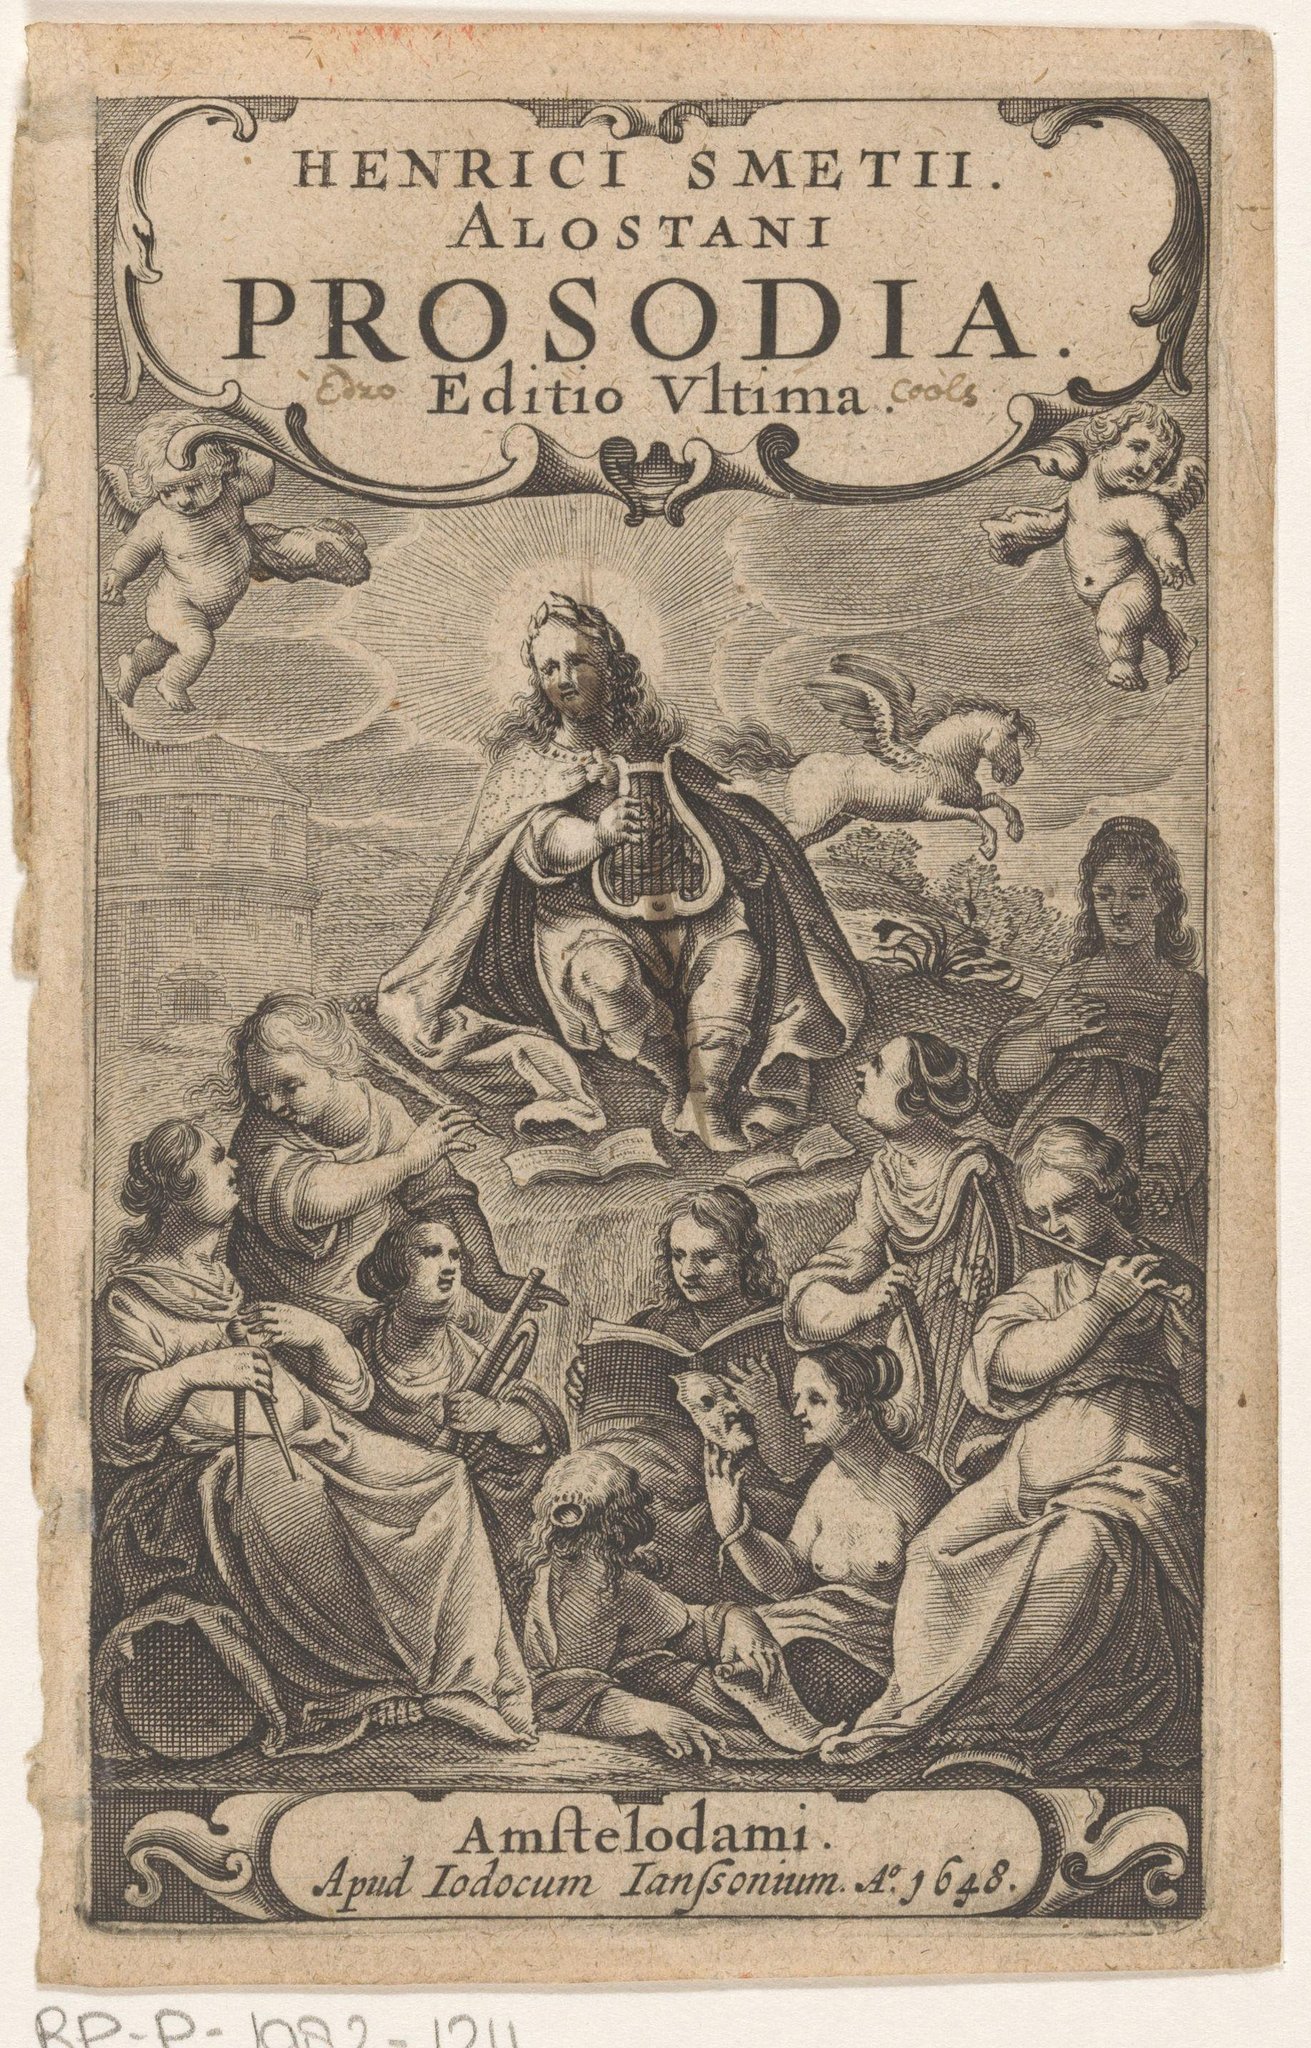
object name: print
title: Titelpagina voor: Henricus Smetius, Prosodia, 1648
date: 1648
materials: paper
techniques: engraving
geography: amsterdam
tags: (story of) apollo (phoebus), parnassus, sacred to apollo musagetes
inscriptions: collector's mark: Lugt 2228, collector's mark: Lugt 2760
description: Titelpagina voor: Smetius, Henricus. Prosodia. Amsterdam: Janssonius, Johannes, 1648.